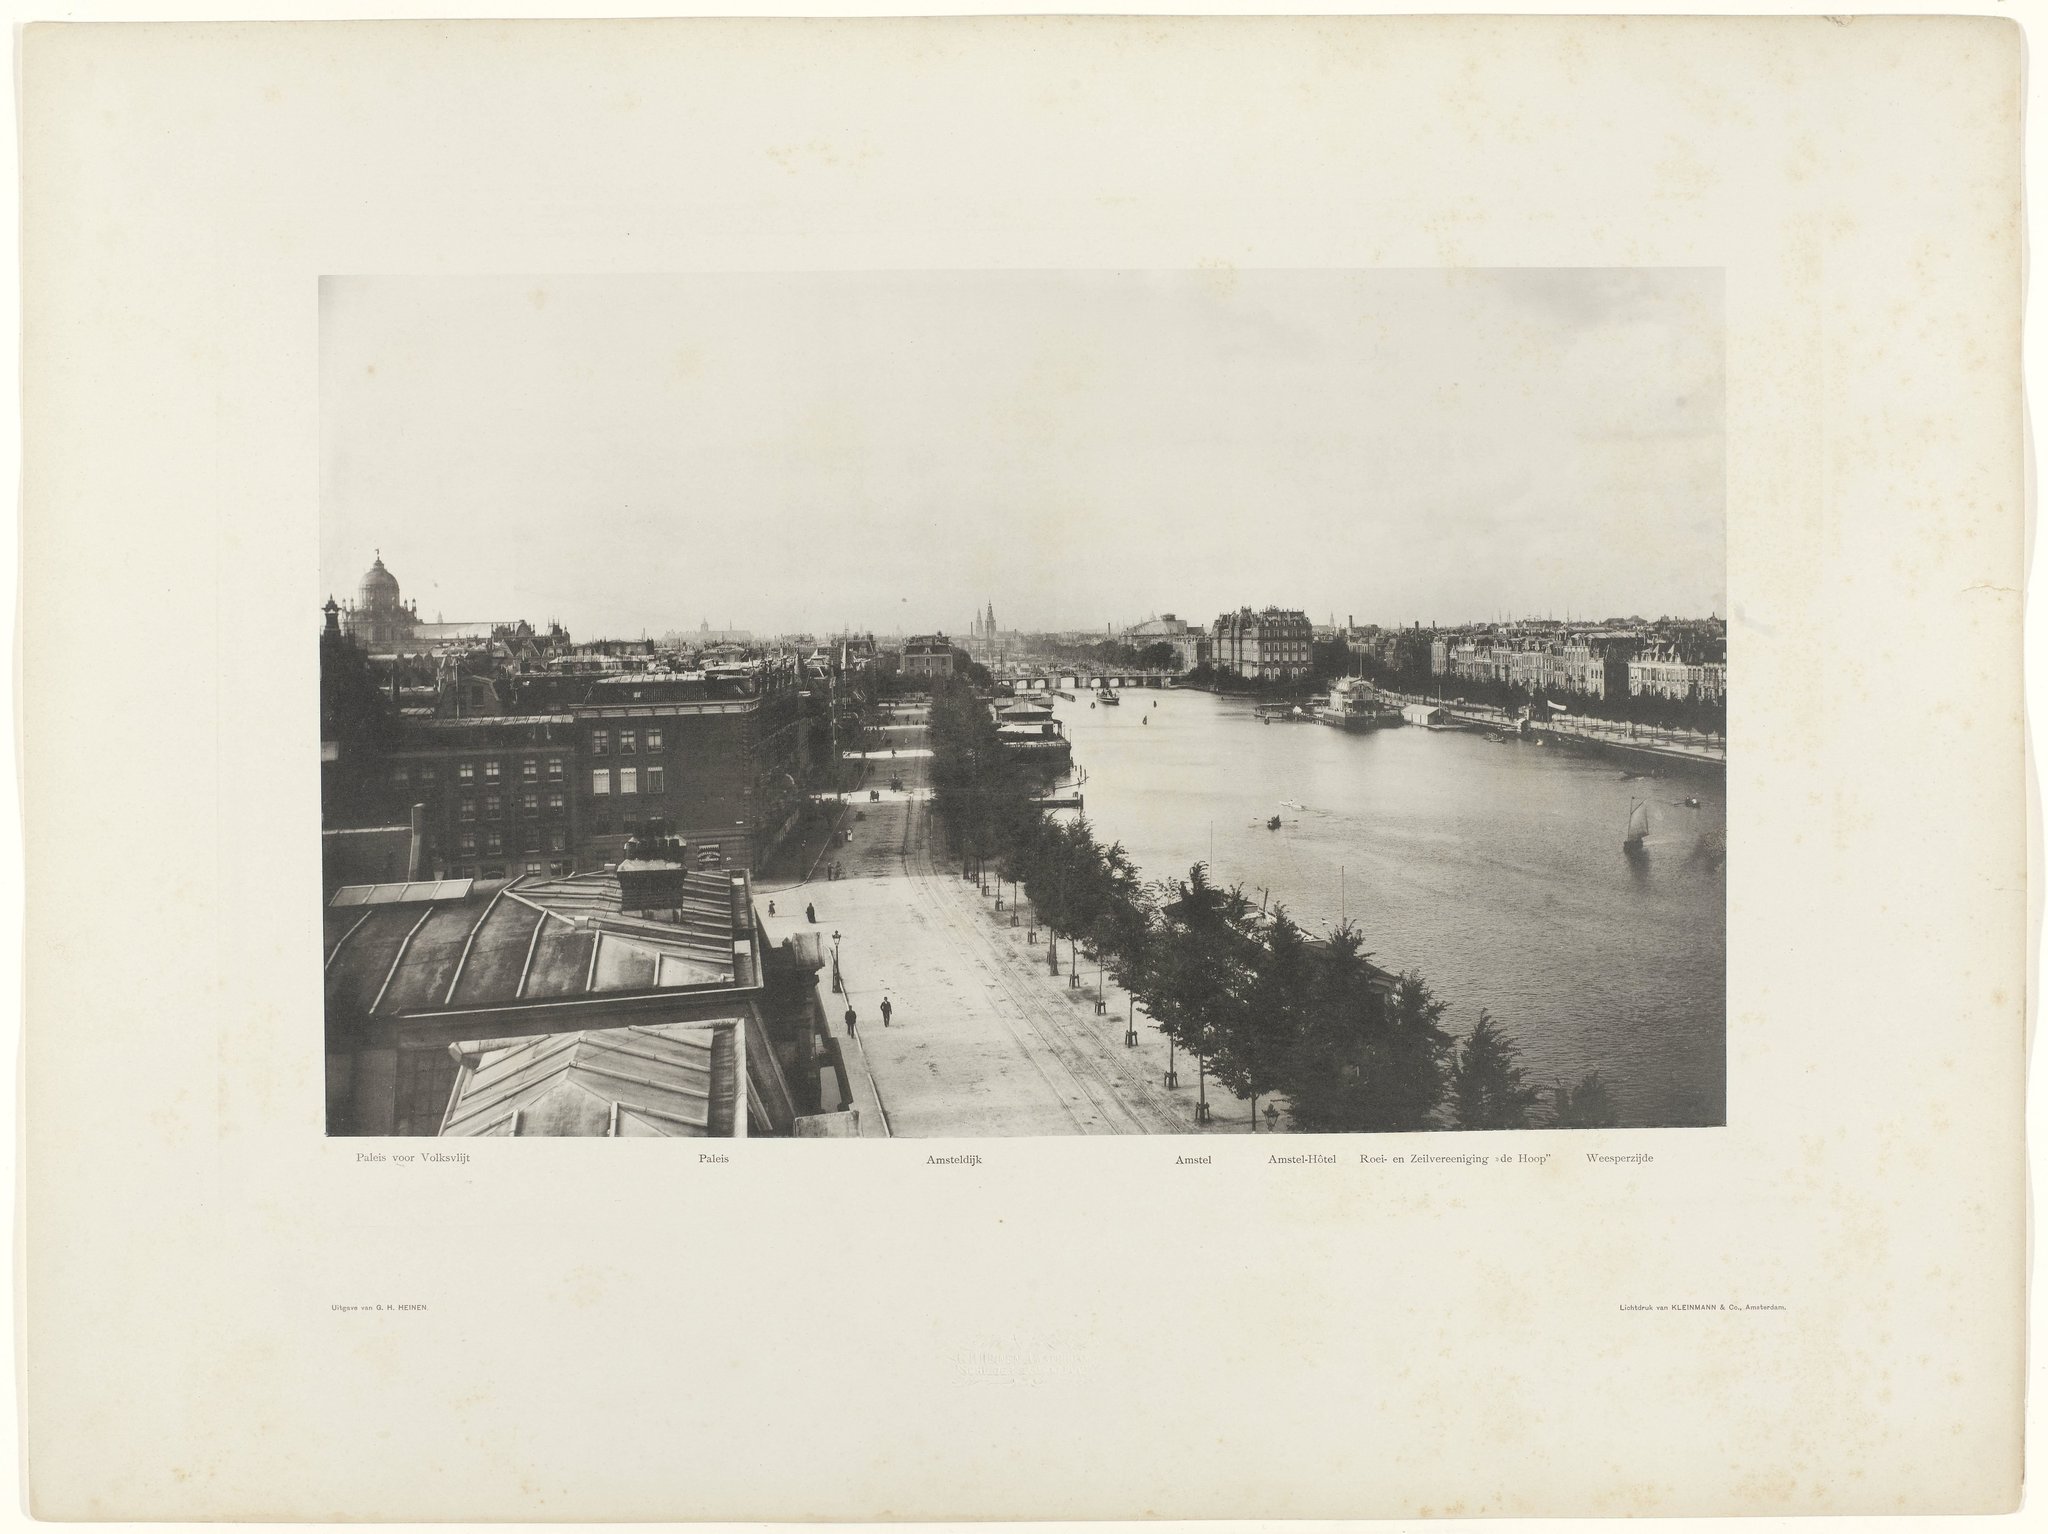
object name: photomechanical print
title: Amsteldijk bij de Ceintuurbaan, gezien naar het noorden vanaf het dak van een woonhuis aan Amsteldijk 42, Amsterdam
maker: gerrit hendricus heinen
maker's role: painter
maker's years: 1851-1930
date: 1894-1898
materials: paper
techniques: photograph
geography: amsterdam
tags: urban housing, city-view in general; 'veduta', canals, waters (in city), amsterdam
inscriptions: check stamp: ‘G.H. Heinen Amsterdam/ Schilder & Fotograaf’